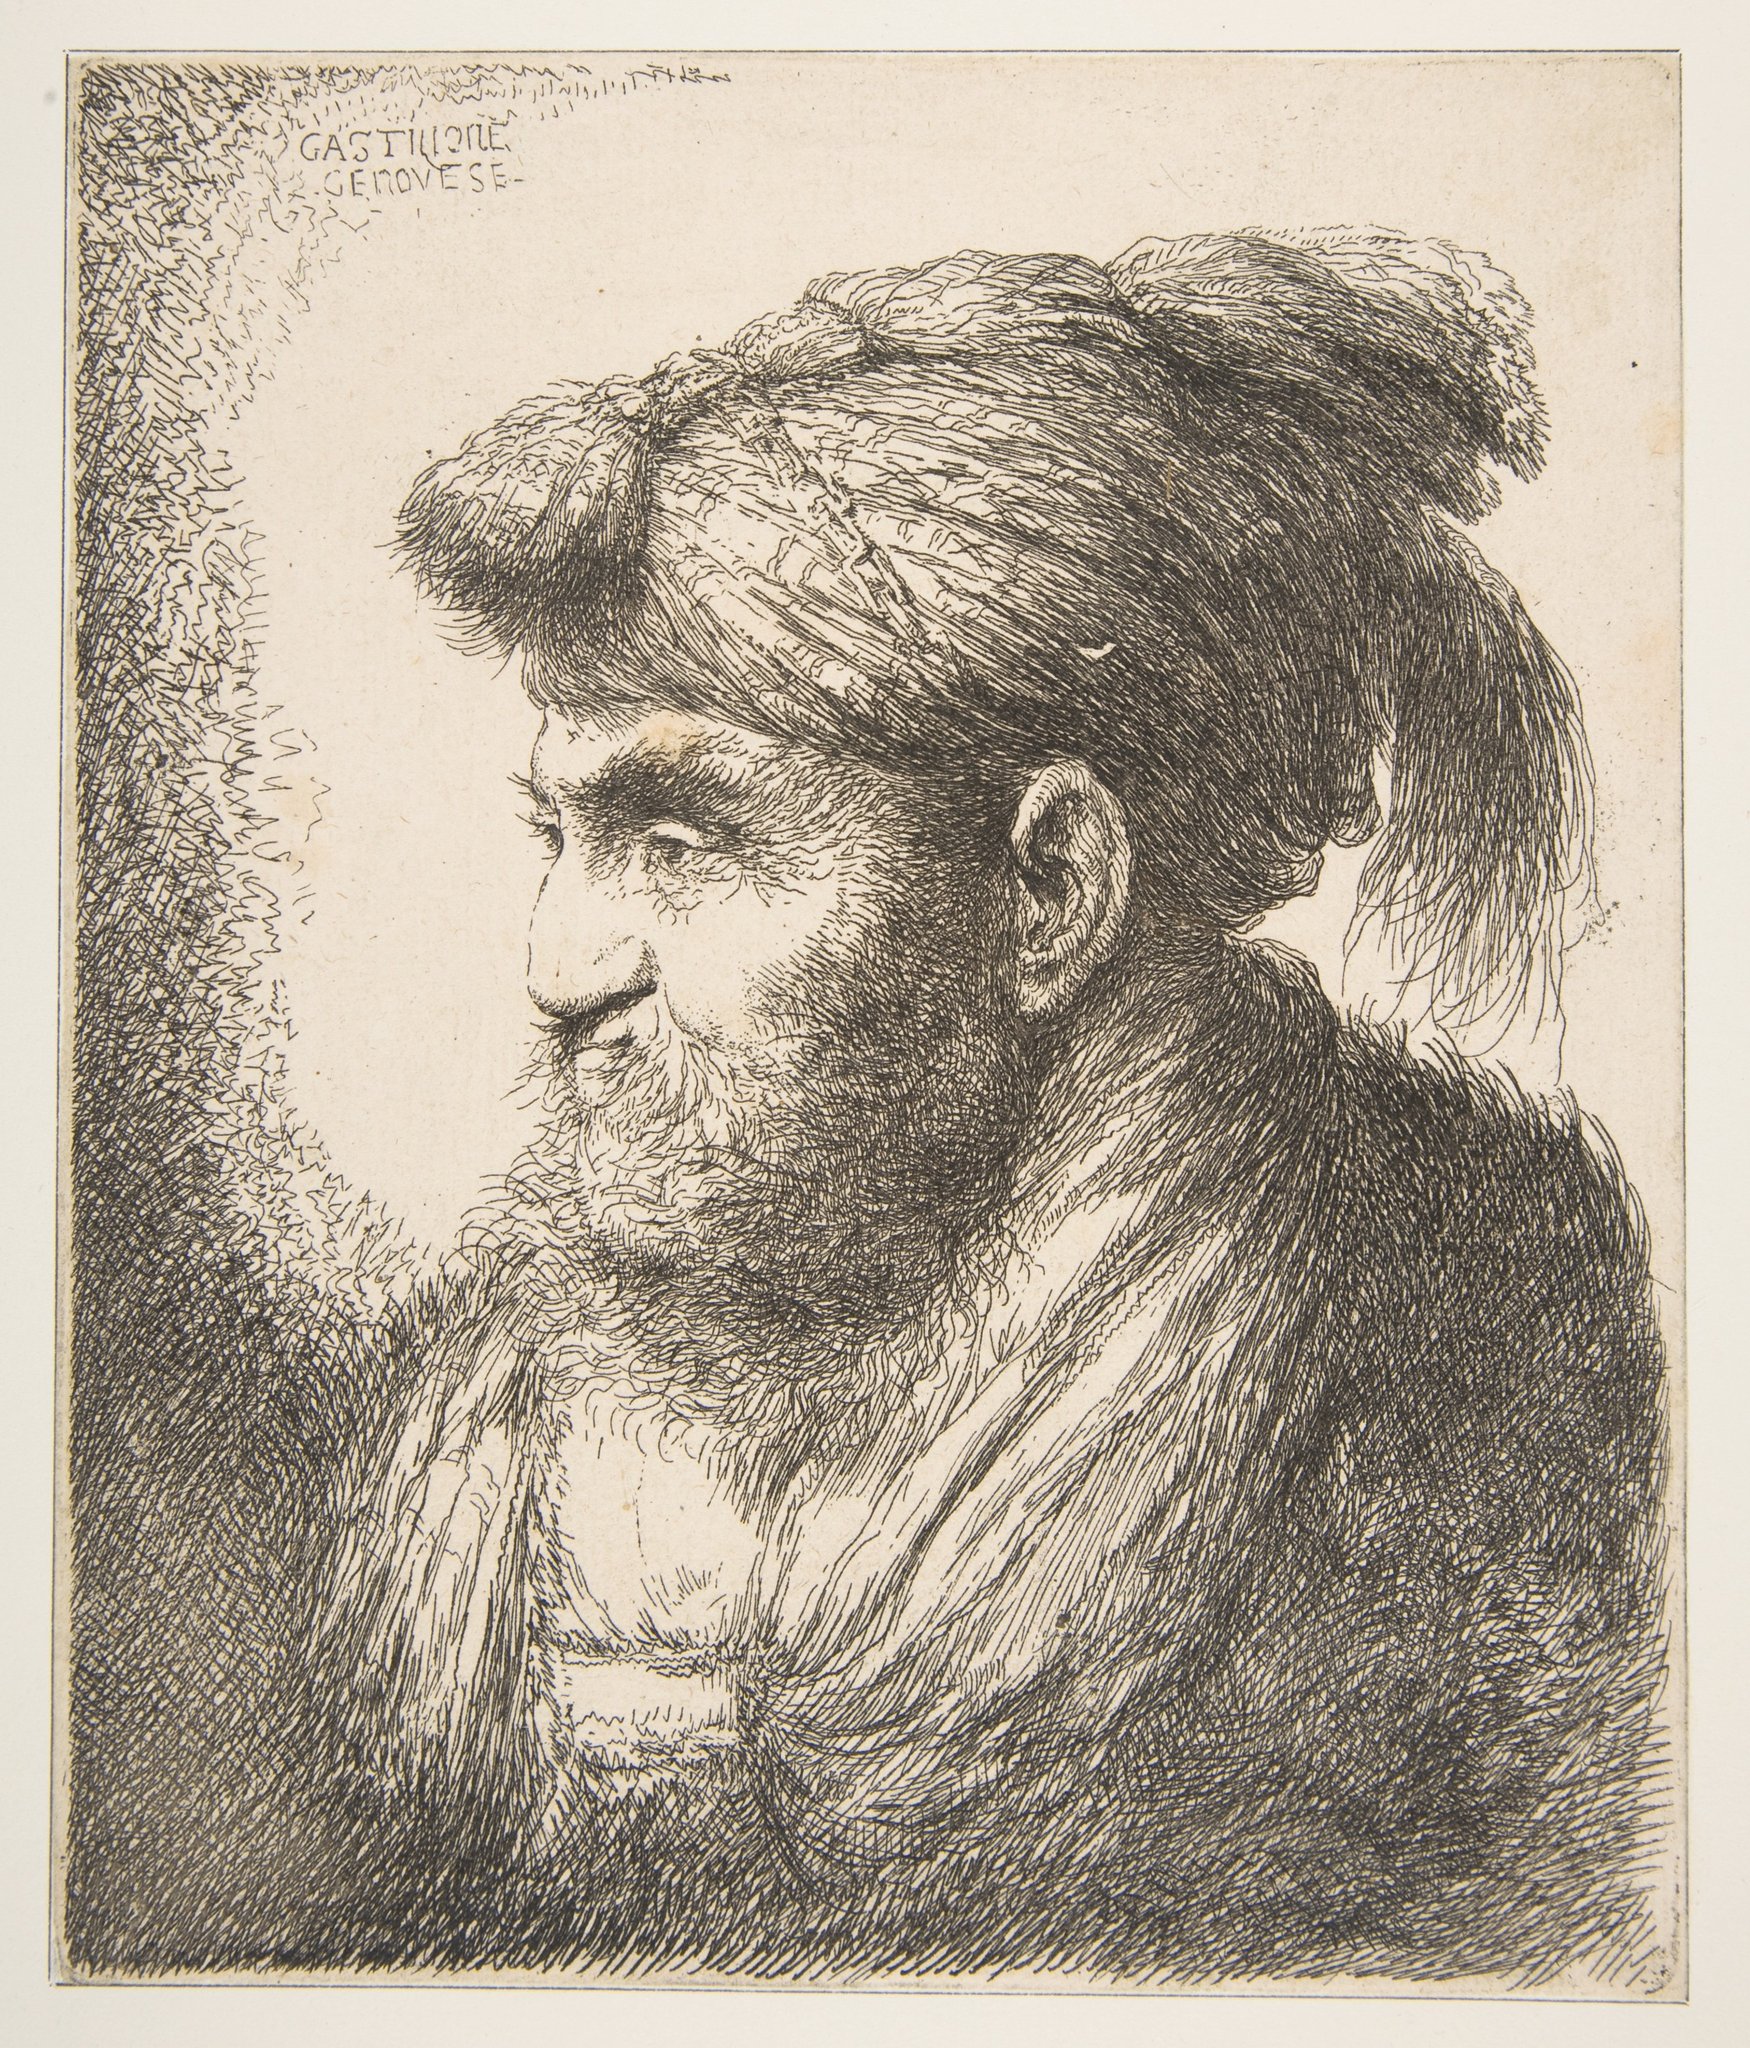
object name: print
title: Man wearing a turban facing left, from "Large Oriental Heads"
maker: giovanni benedetto castiglione (il grechetto)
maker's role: artist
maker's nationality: italian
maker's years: 1609-1664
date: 1645-1650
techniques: etching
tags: men,profiles